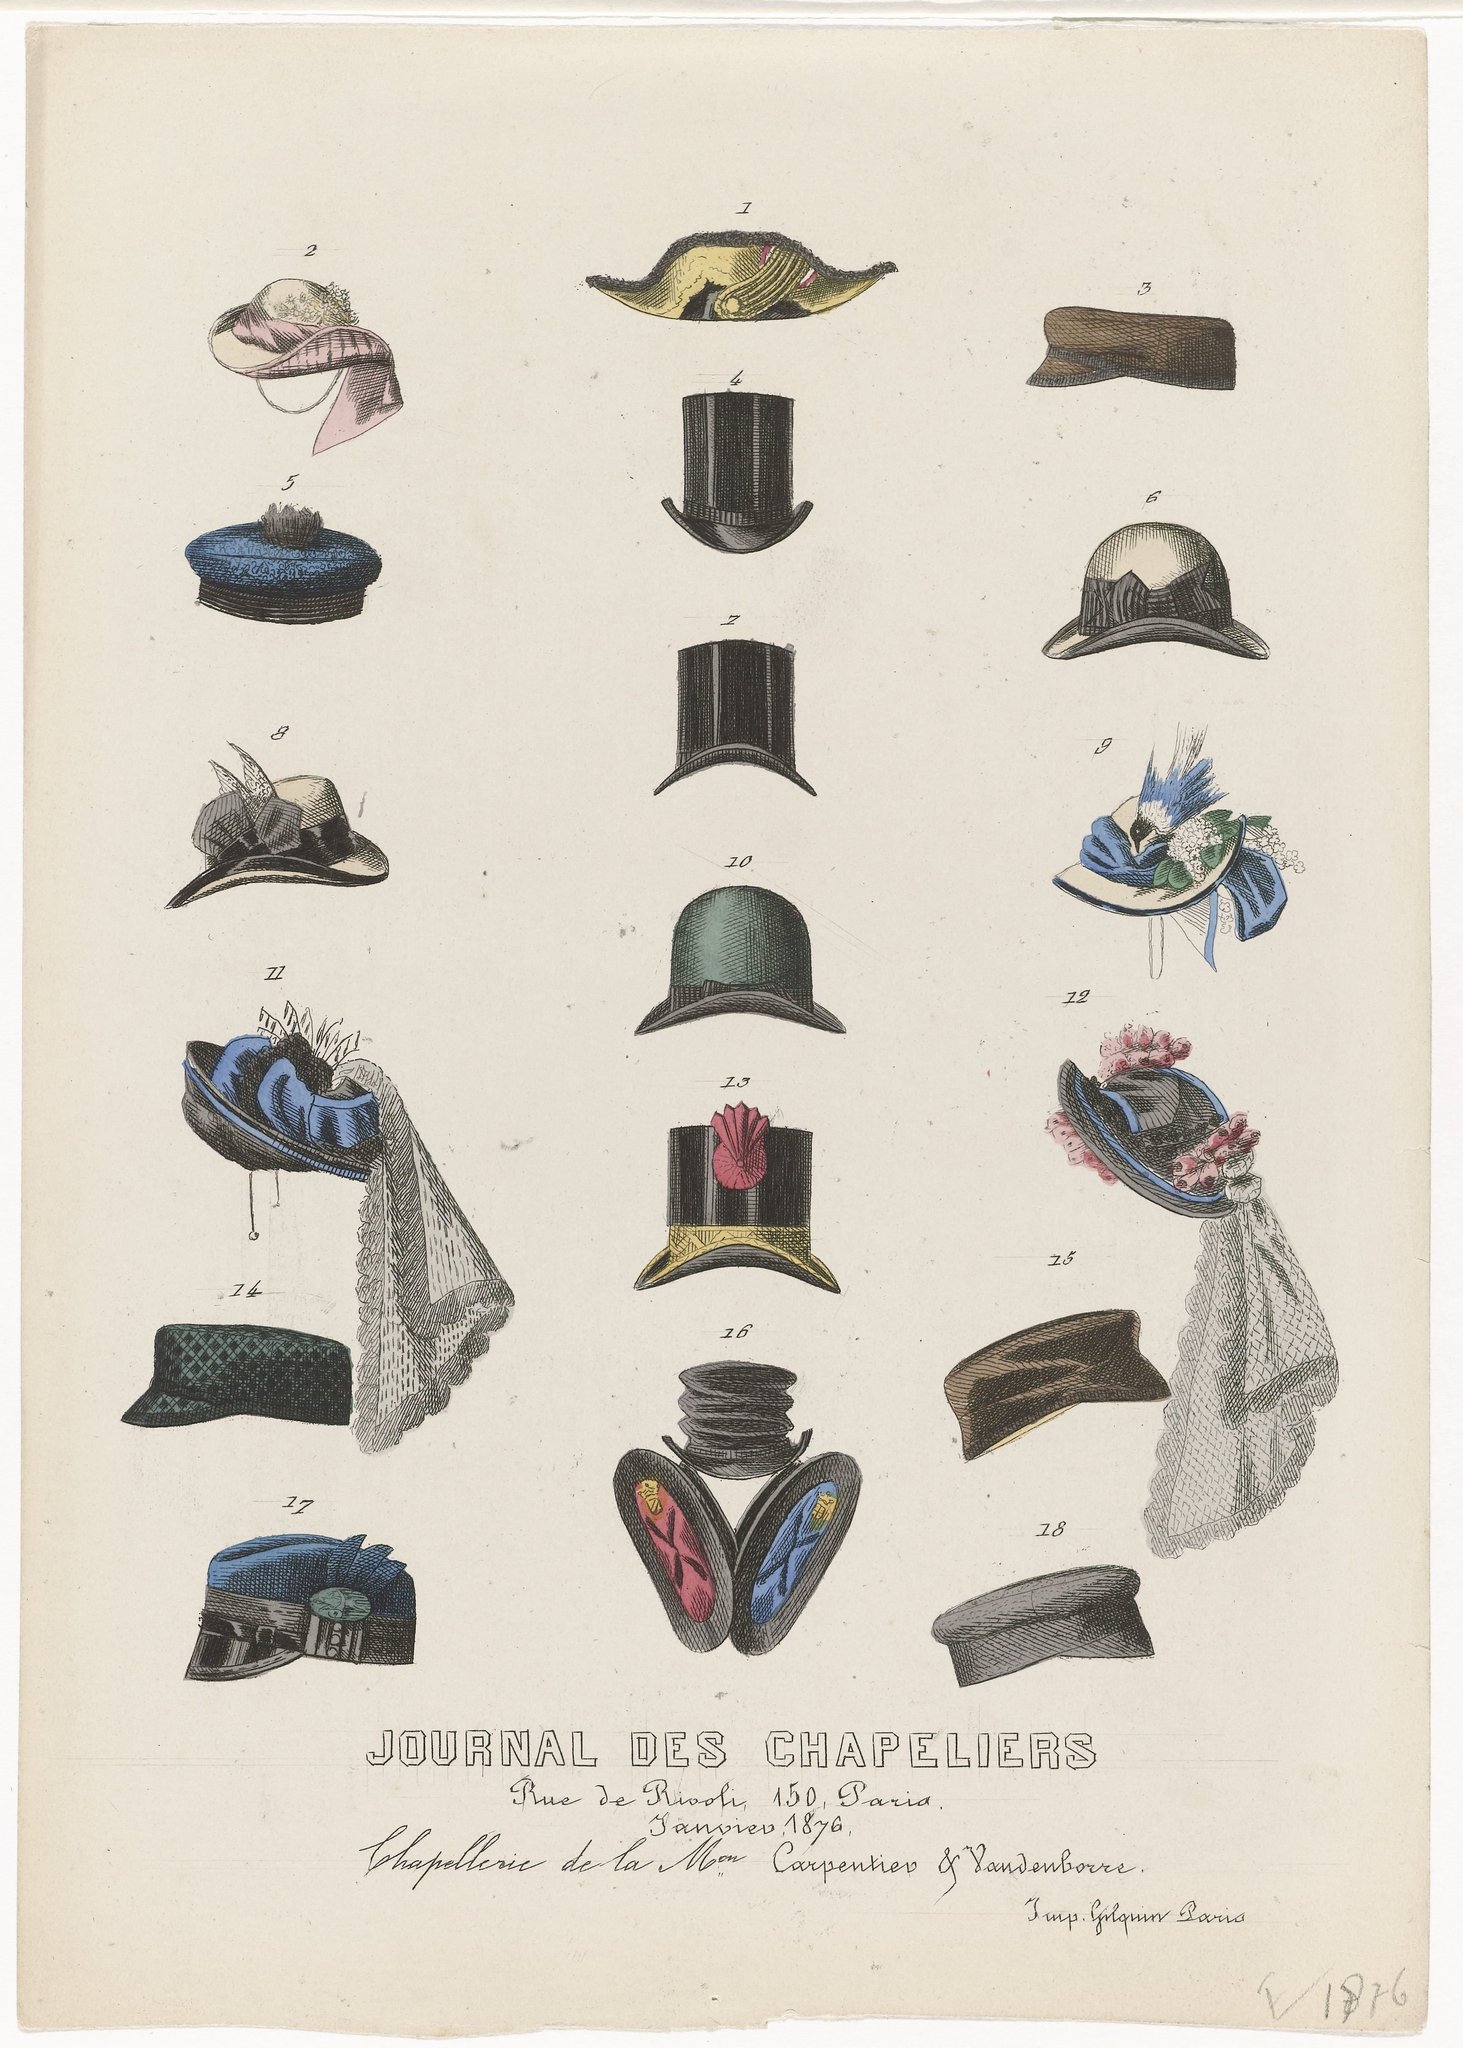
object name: fashion print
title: Journal des Chapeliers, janvier 1876 : Chapellerie de la Mon (...)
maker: Anonymous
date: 1876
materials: paper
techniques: engraving, hand coloring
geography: paris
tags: veil (+ women's clothes), head-gear: hat (+ men's clothes), fashion plates, head-gear: hat (+ women's clothes), head-gear: hat (+ feathers used for clothes)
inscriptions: title: ‘Journal des Chapeliers’, address: ‘Rue de Rivoli 150, Paris / Janvier 1876.’, caption: ‘Chapellerie de la Mon Carpentier & Vandenborre’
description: Achttien verschillende hoofddeksels van de firma Carpentier & Vandenborre. Middenonder (no.16) een 'chapeau claque' (Inklapbare hoge hoed)